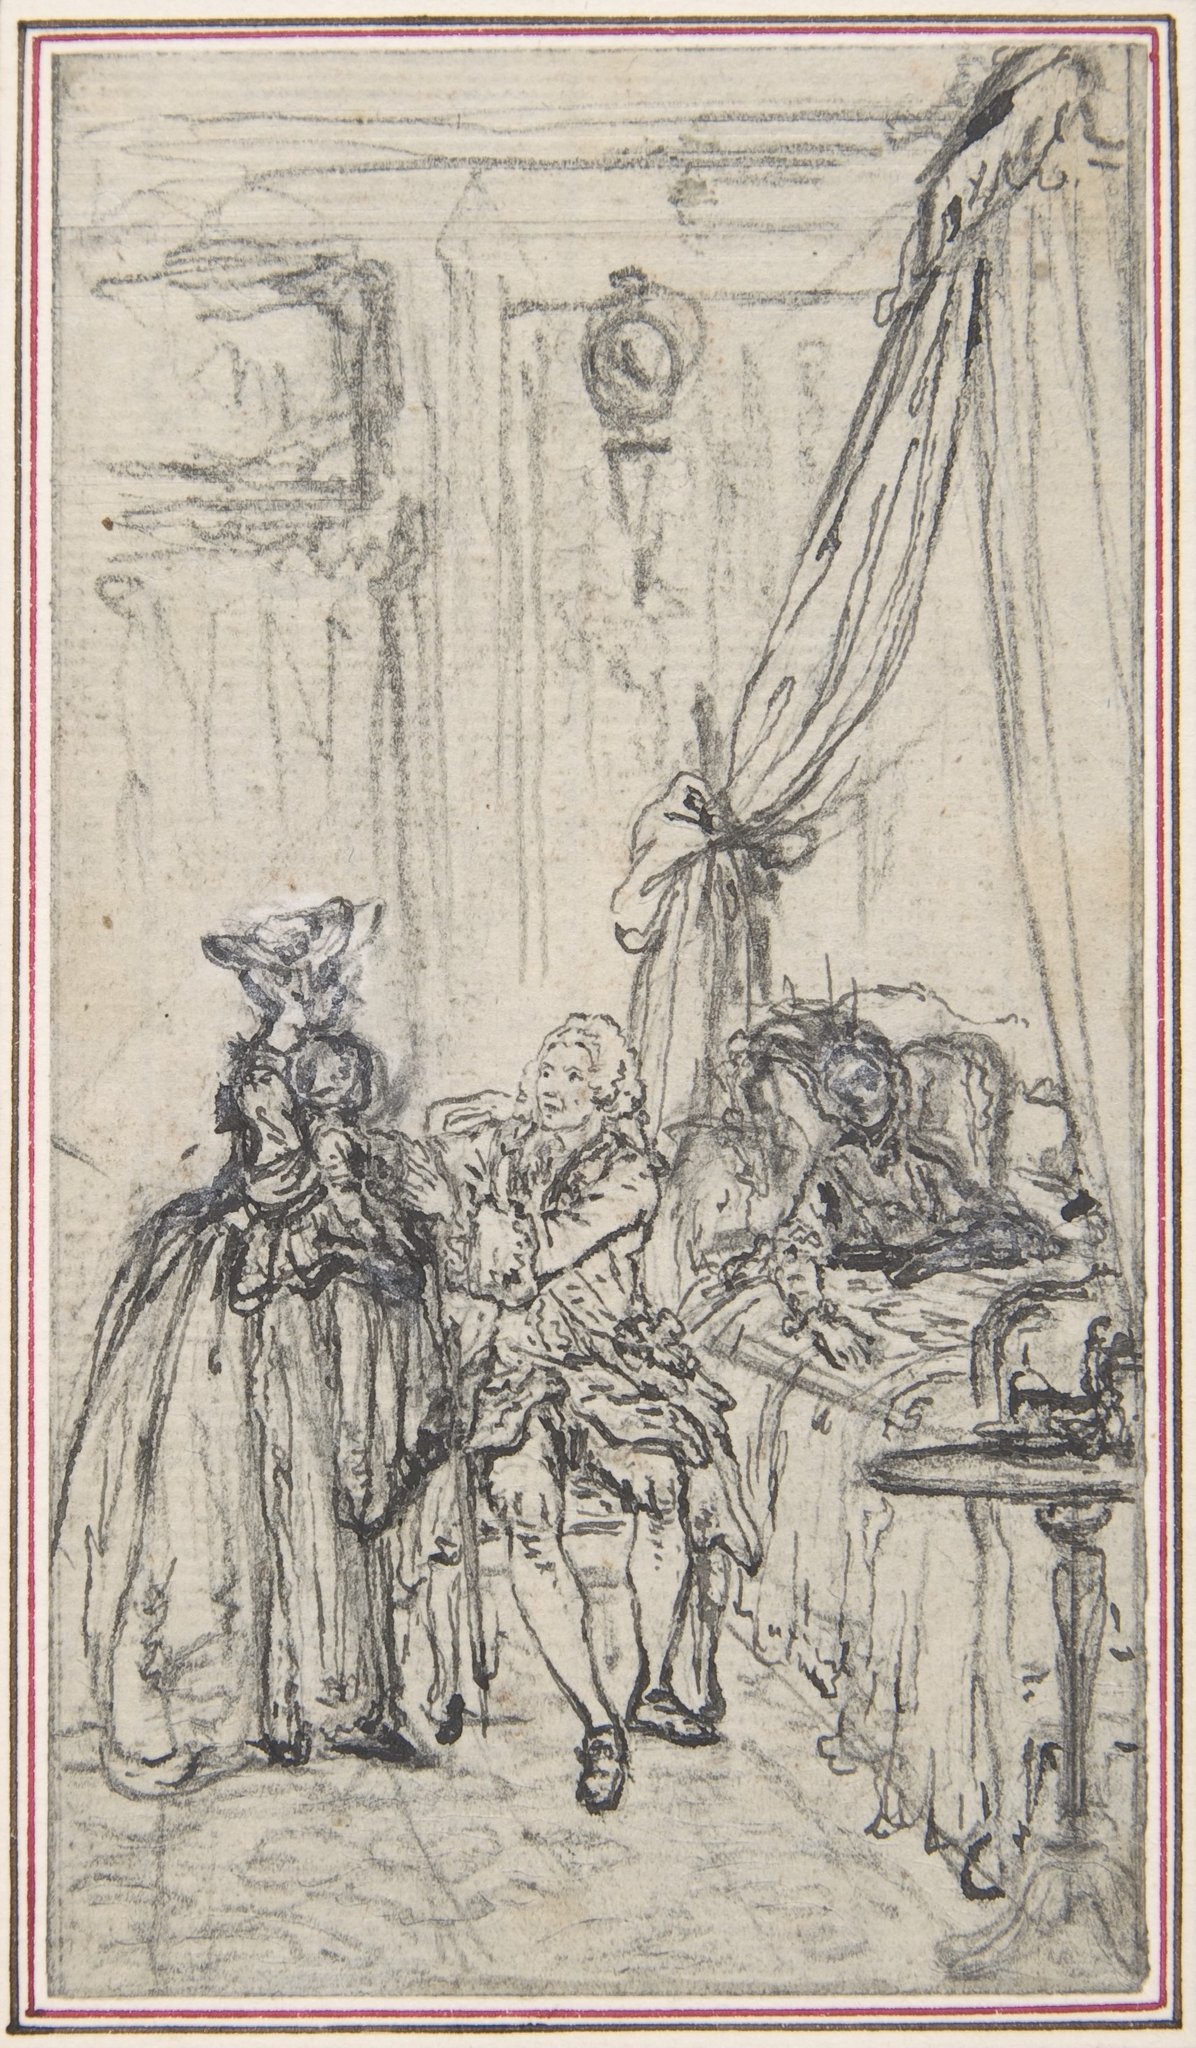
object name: drawing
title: Study for a frontispiece for "Histoire de Miss Jenny"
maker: hubert françois gravelot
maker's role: artist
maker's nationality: french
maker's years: 1699-1773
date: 1701-1800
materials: chalk, ink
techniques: pen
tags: bedrooms,illness,men,women